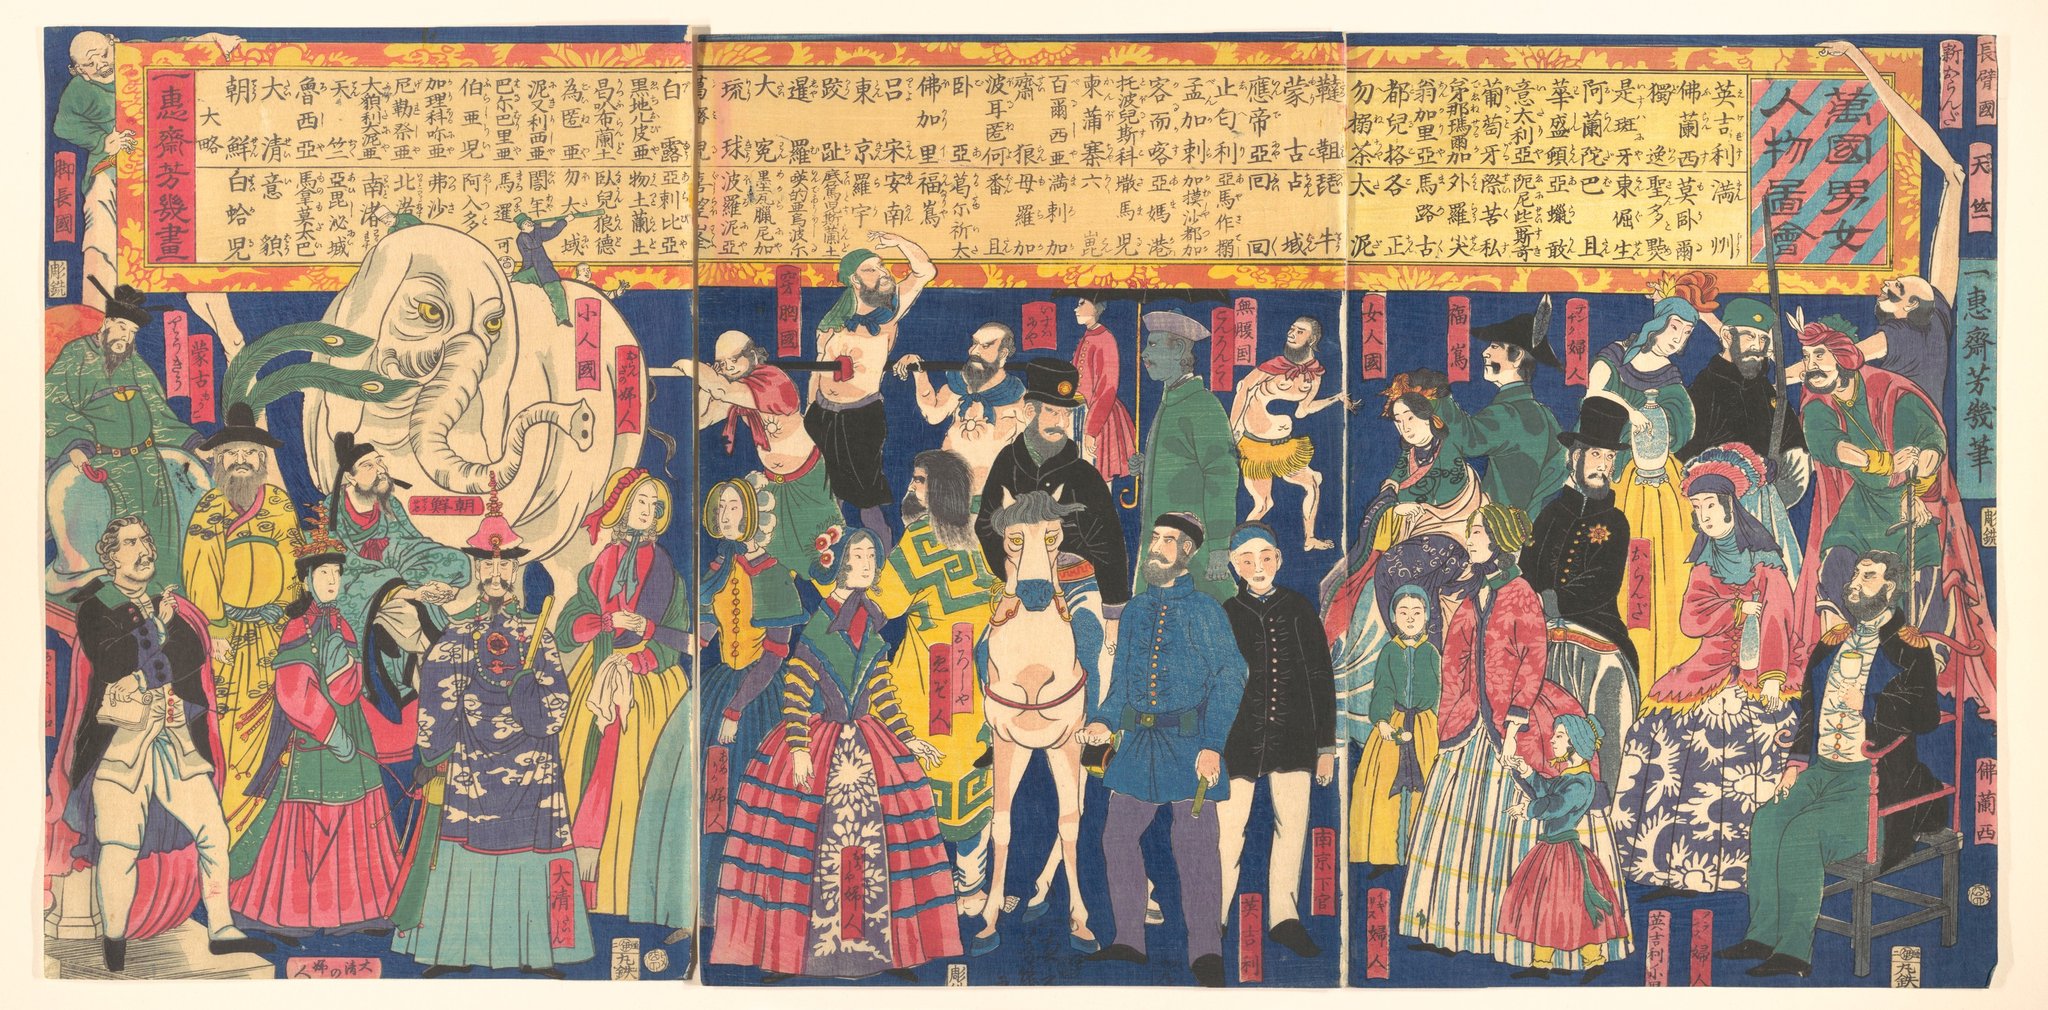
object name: print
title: Picture of Men and Women from all Nations (Bankoku danjo jinbutsu zue)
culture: japanese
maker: utagawa yoshiiku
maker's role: artist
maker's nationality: japanese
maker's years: 1833-1904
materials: ink, paper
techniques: woodblock print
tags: men,women,elephants,horses